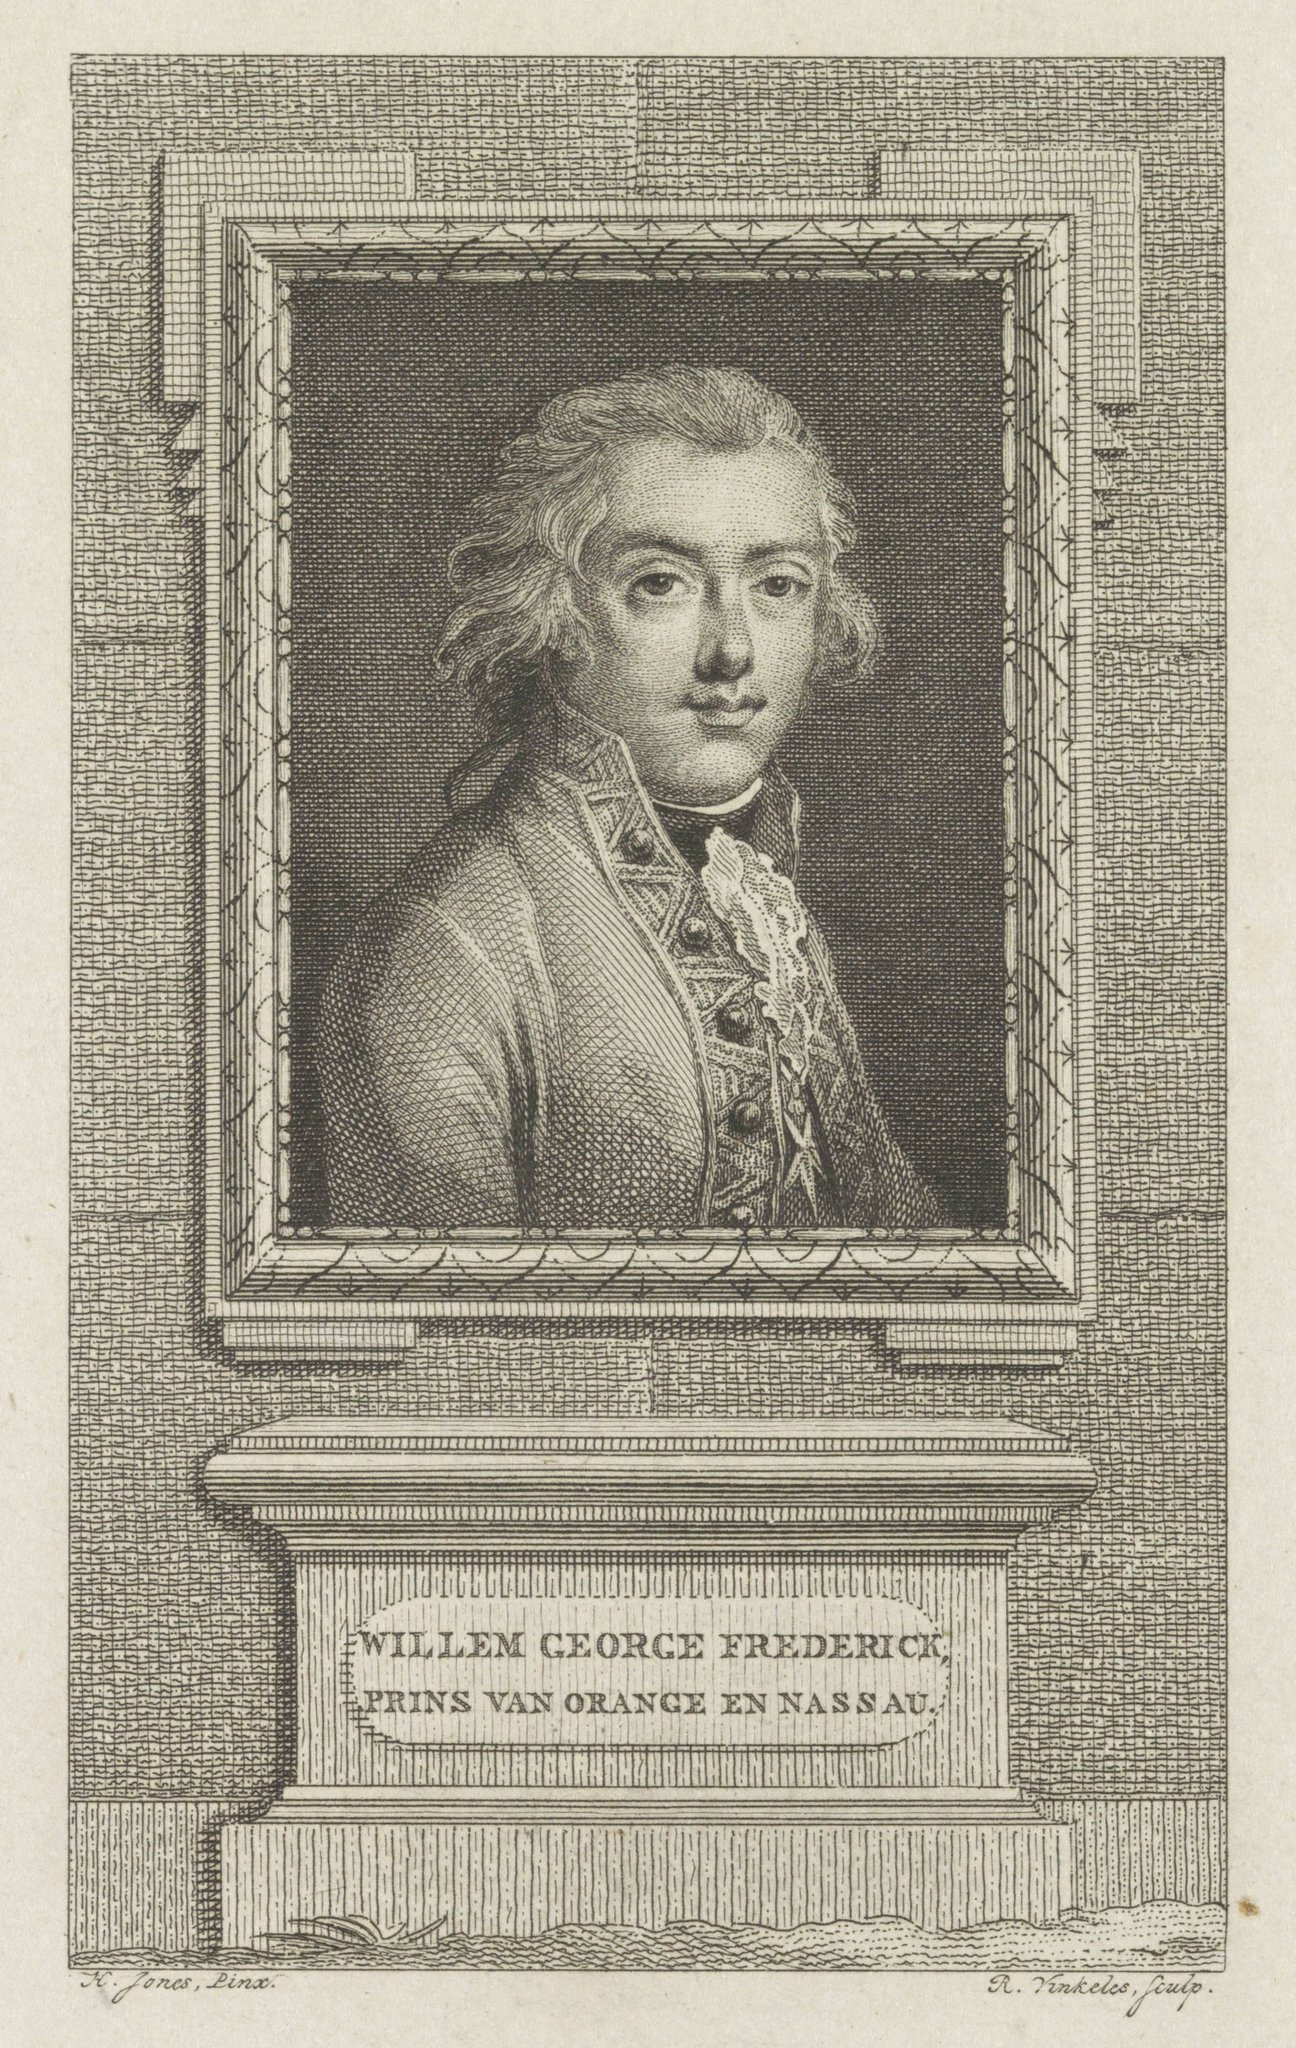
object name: print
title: Portret van Frederik, prins van Oranje-Nassau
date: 1790-1816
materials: paper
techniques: engraving, etching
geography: amsterdam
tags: the hague, willem george frederik (prins van oranje-nassau)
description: De hier vermelde titel verwijst naar de hoogst verkregen titel van de geportretteerde, niet per se naar de titel die de geportretteerde op deze voorstelling draagt.